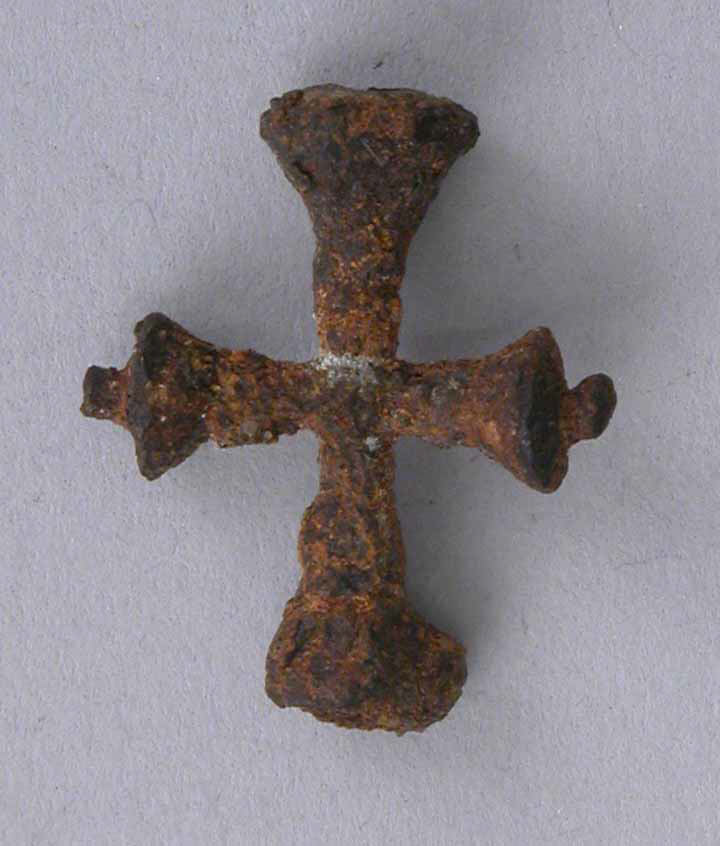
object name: cross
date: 201-1200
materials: iron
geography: egypt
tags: cross